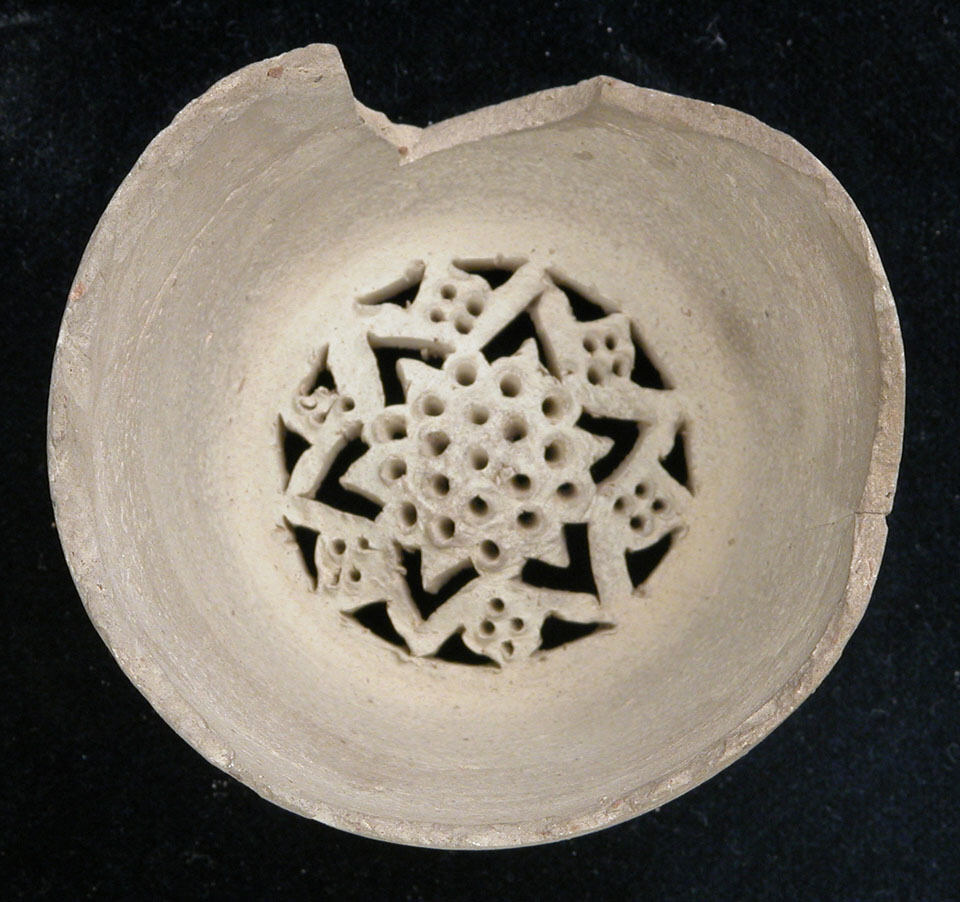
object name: water filter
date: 901-1200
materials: earthenware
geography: egypt